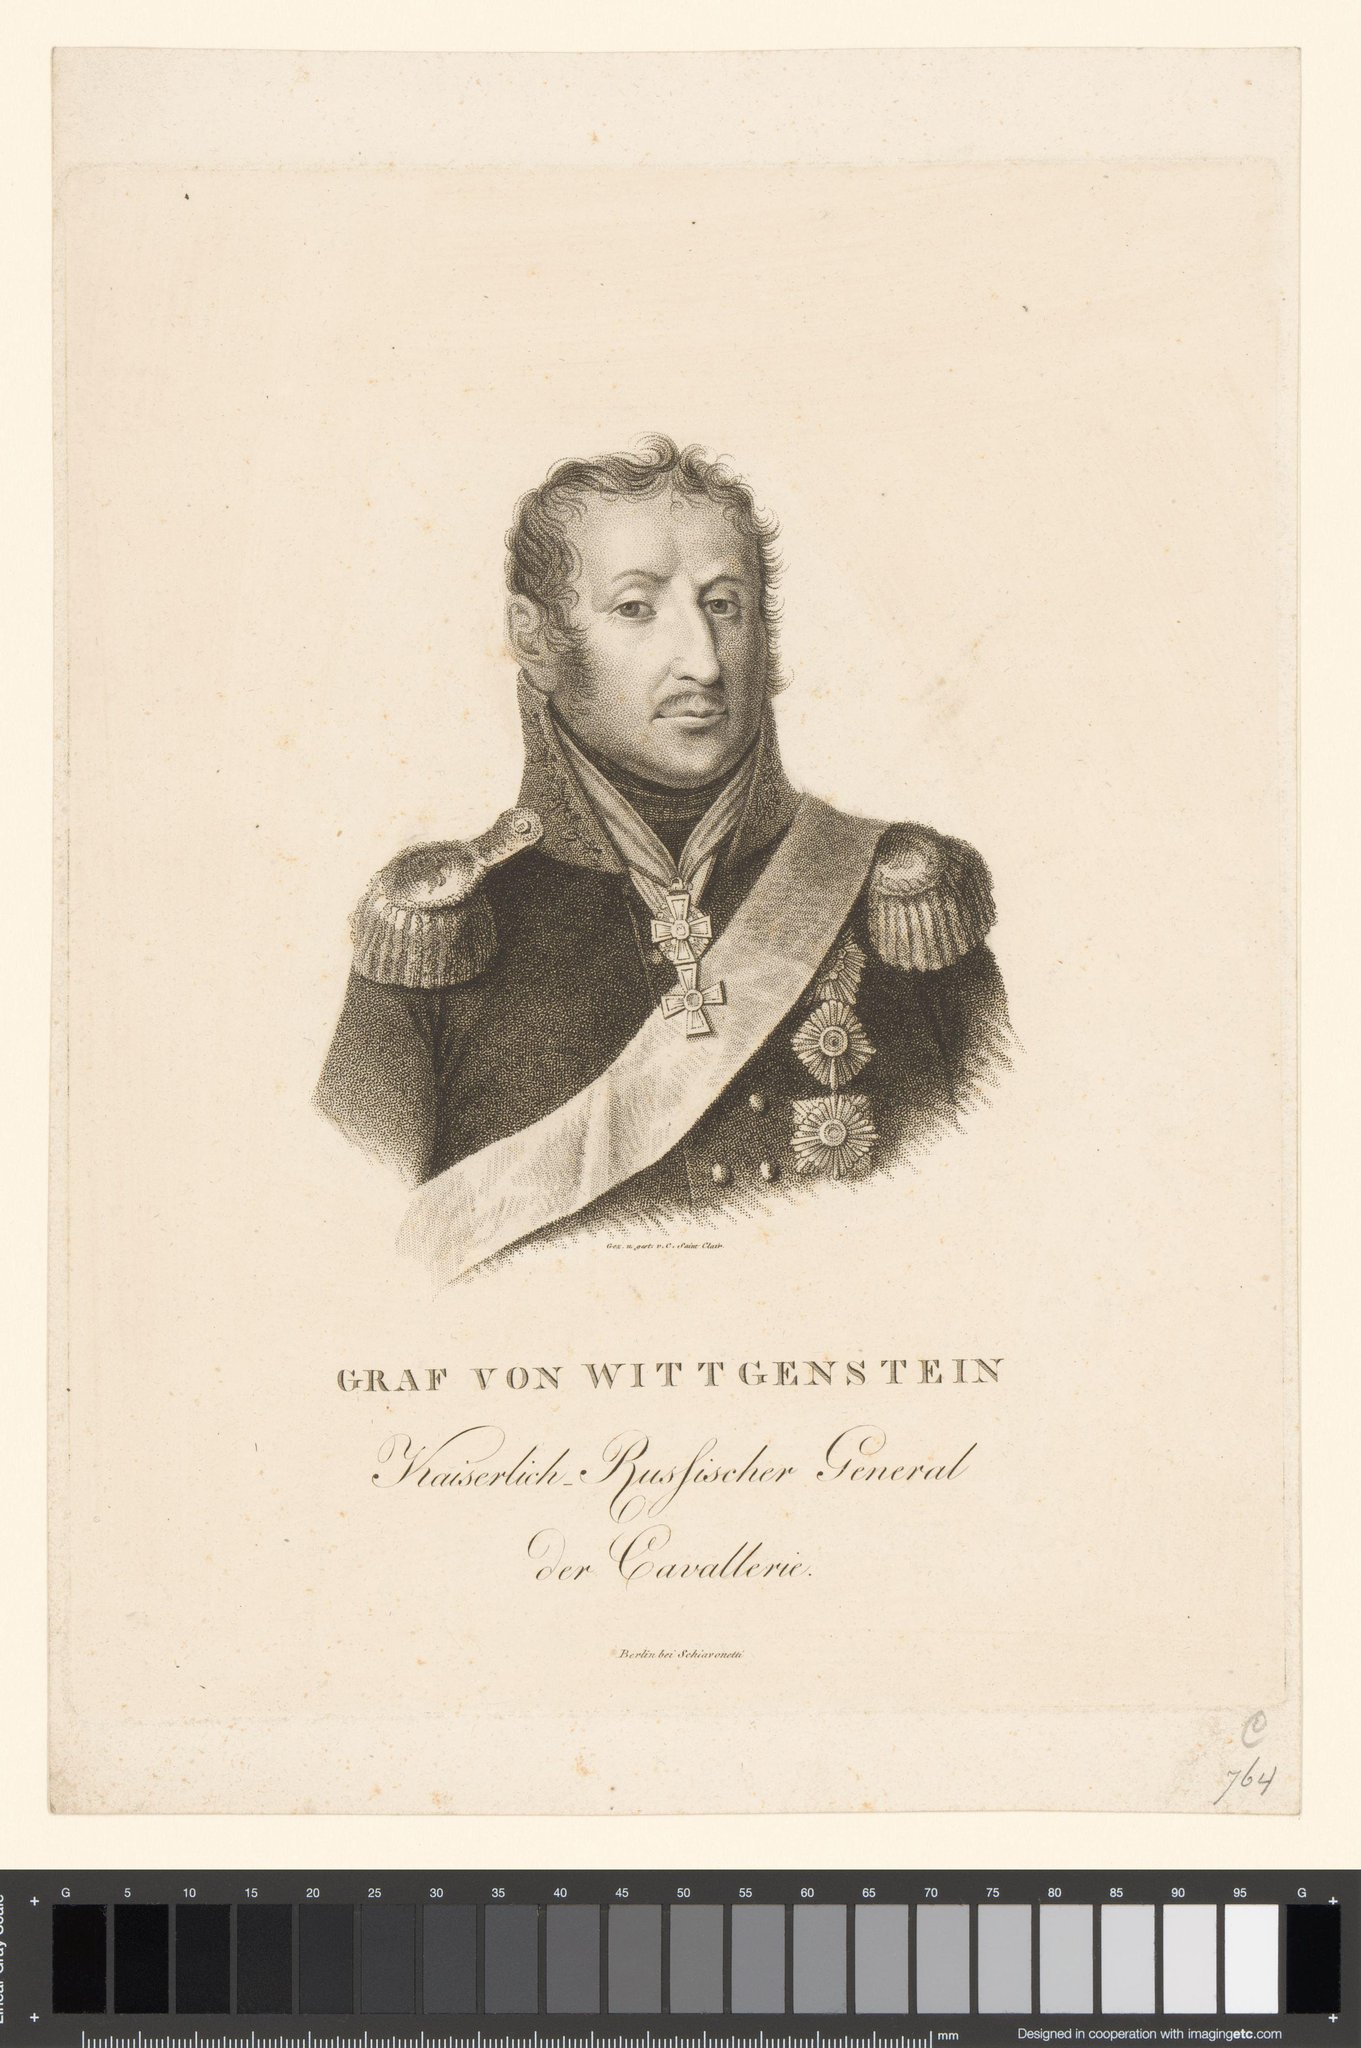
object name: print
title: Portret van Ludwig Adolph Peter, Fürst von Sayn-Wittgenstein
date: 1800-1899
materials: paper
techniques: engraving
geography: berlin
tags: historical persons, medals and other marks of military honour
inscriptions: collector's mark: Lugt 2228